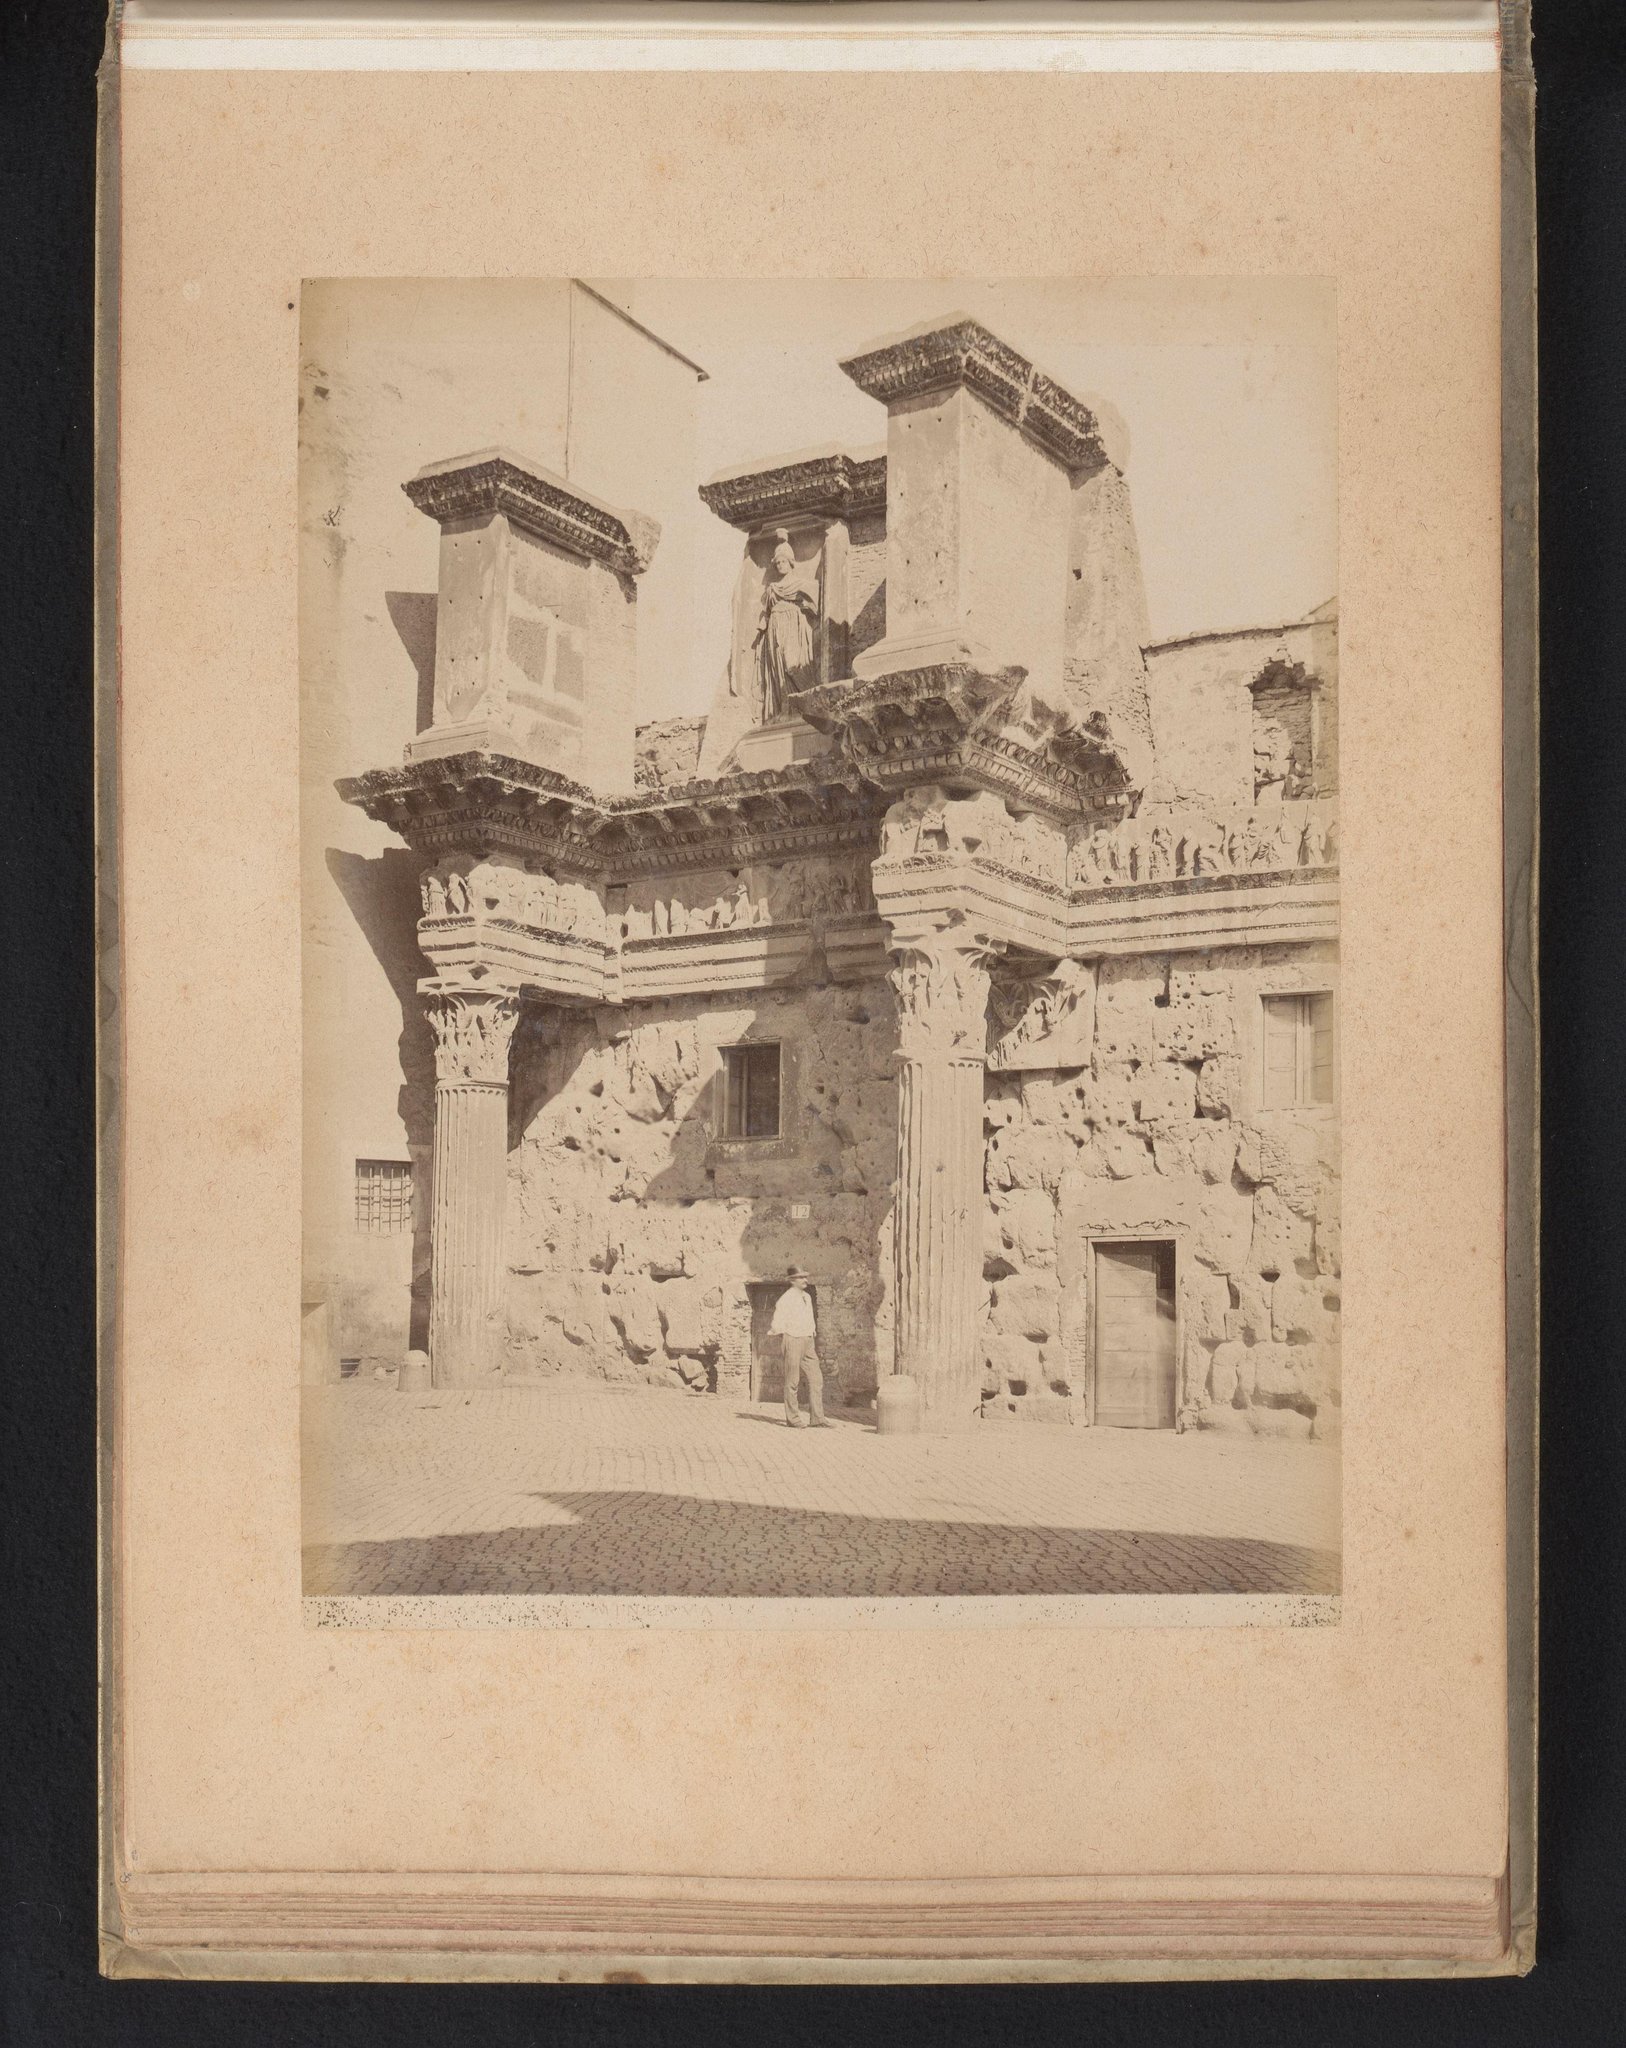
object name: photograph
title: Gezicht op de tempel van Minerva op het Forum van Nerva in Rome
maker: Anonymous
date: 1870-1895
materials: cardboard, photographic support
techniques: albumen print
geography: rome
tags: (story of) mars (ares), ruin of a building ~ architecture, temple, shrine ~ roman religion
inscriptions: inscription: ‘[...] TEMPIO DI MINERVA’